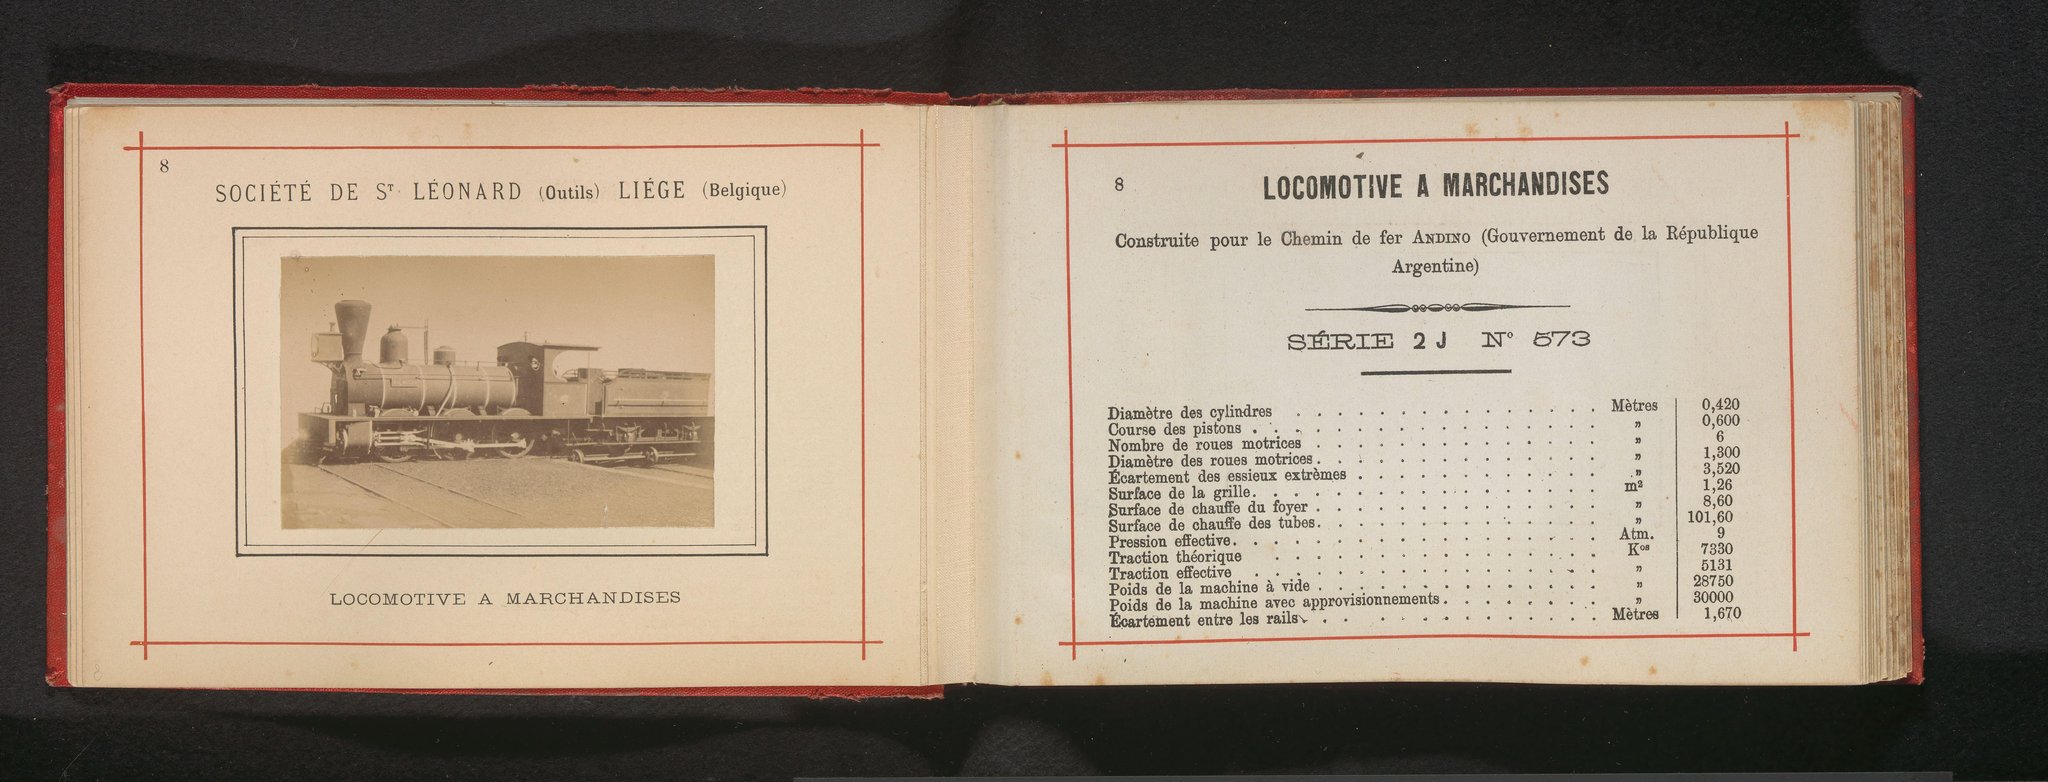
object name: page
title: Locomotief voor een goederentrein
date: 1880-1885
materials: photographic support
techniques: albumen print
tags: locomotive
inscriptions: inscription: ‘Société de St. Léonard (Outils) Liége (Belgique)’